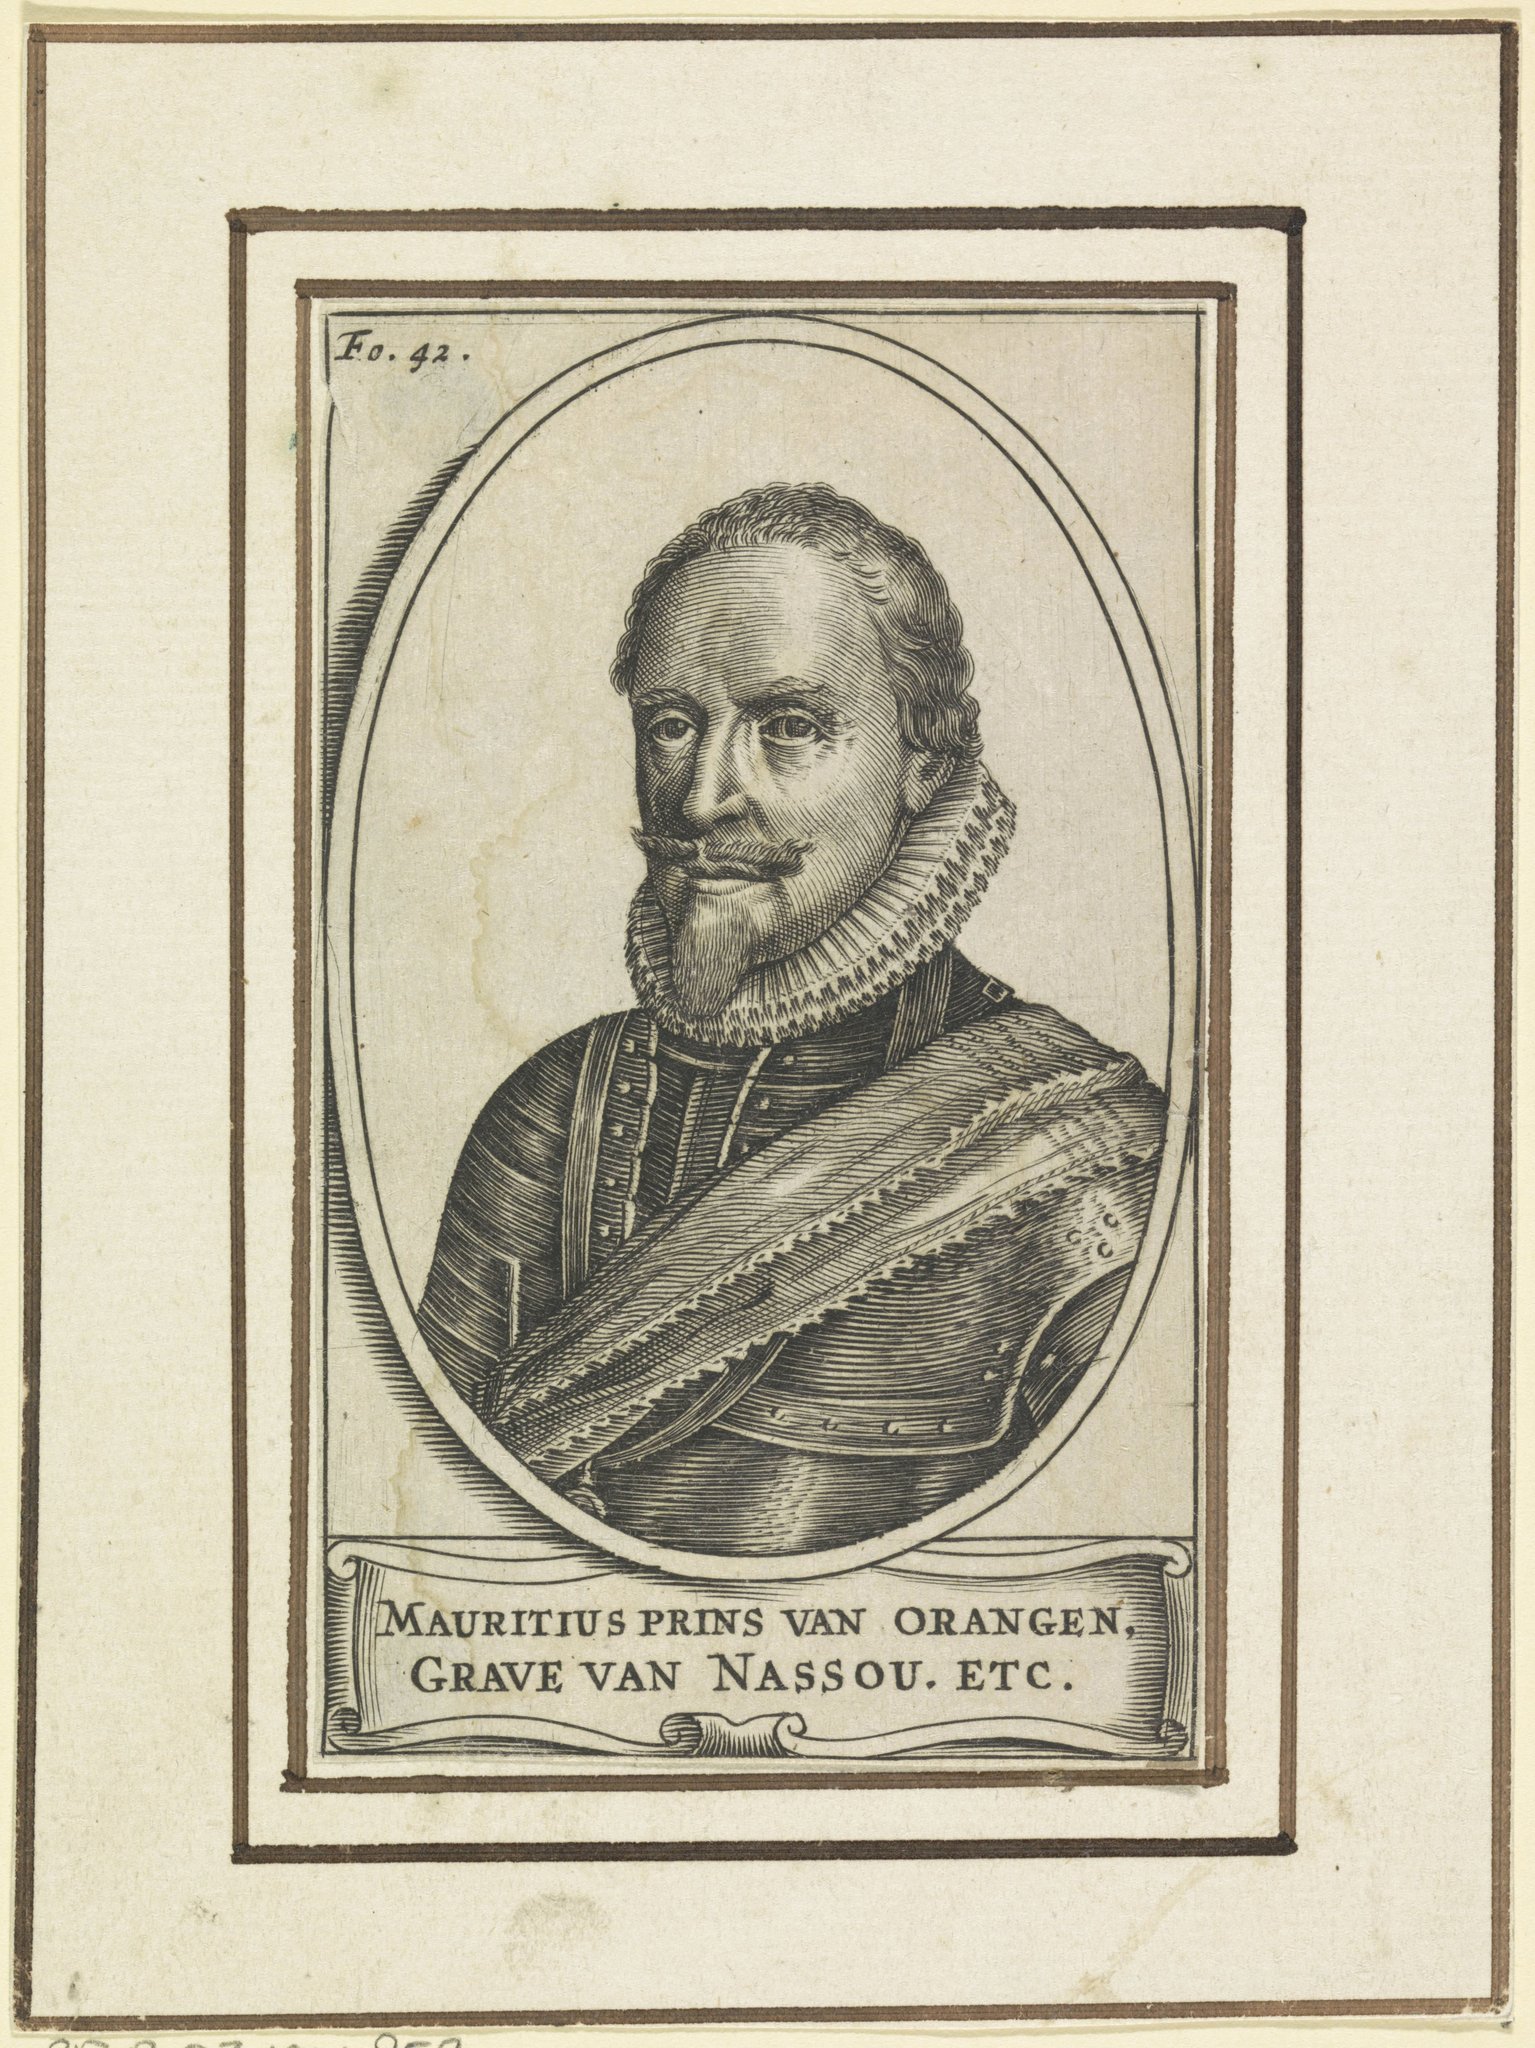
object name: print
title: Portret van Maurits, prins van Oranje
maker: Anonymous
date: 1600-1699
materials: paper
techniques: engraving, etching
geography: low countries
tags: the hague, maurice (prince of orange), knighthood order (garter) - insignia of a knighthood order, e.g.: badge, chain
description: De hier vermelde titel verwijst naar de hoogst verkregen titel van de geportretteerde, niet per se naar de titel die de geportretteerde op deze voorstelling draagt.